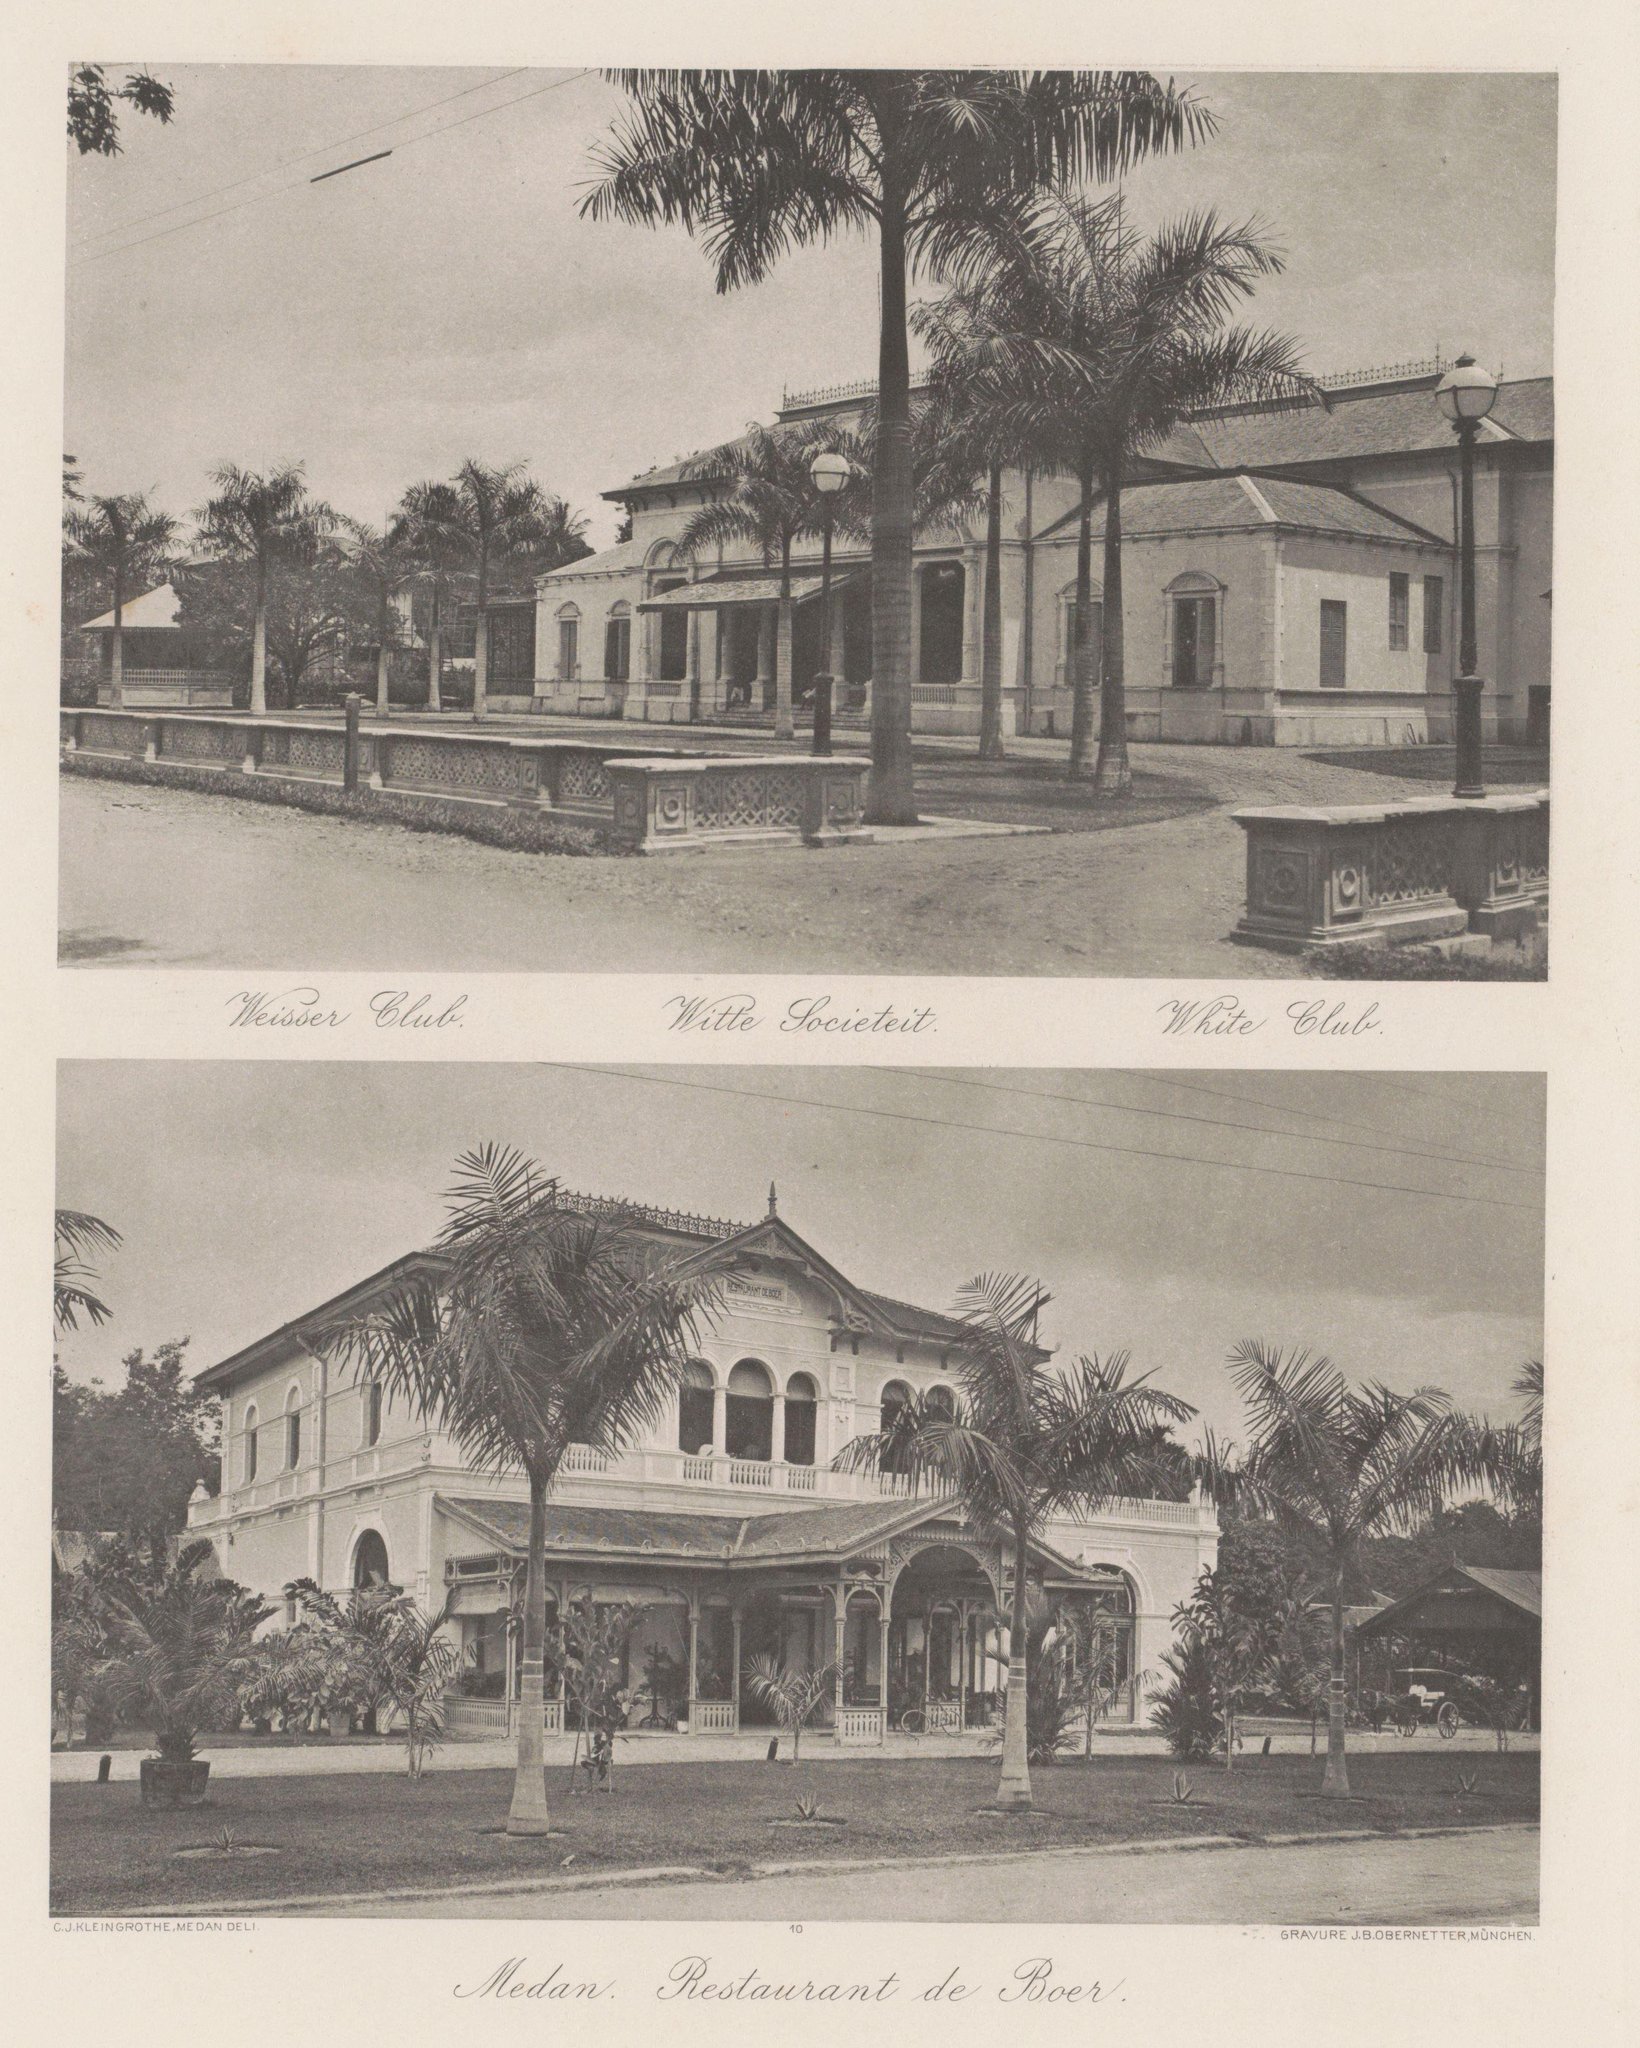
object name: photomechanical print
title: Witte Sociëteit (boven) en restaurant De Boer (onder) in Medan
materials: paper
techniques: photoaquatint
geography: medan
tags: club, meeting place, restaurant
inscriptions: number: ‘10’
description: Onderdeel van Album met heliogravures van Sumatra's oostkust.